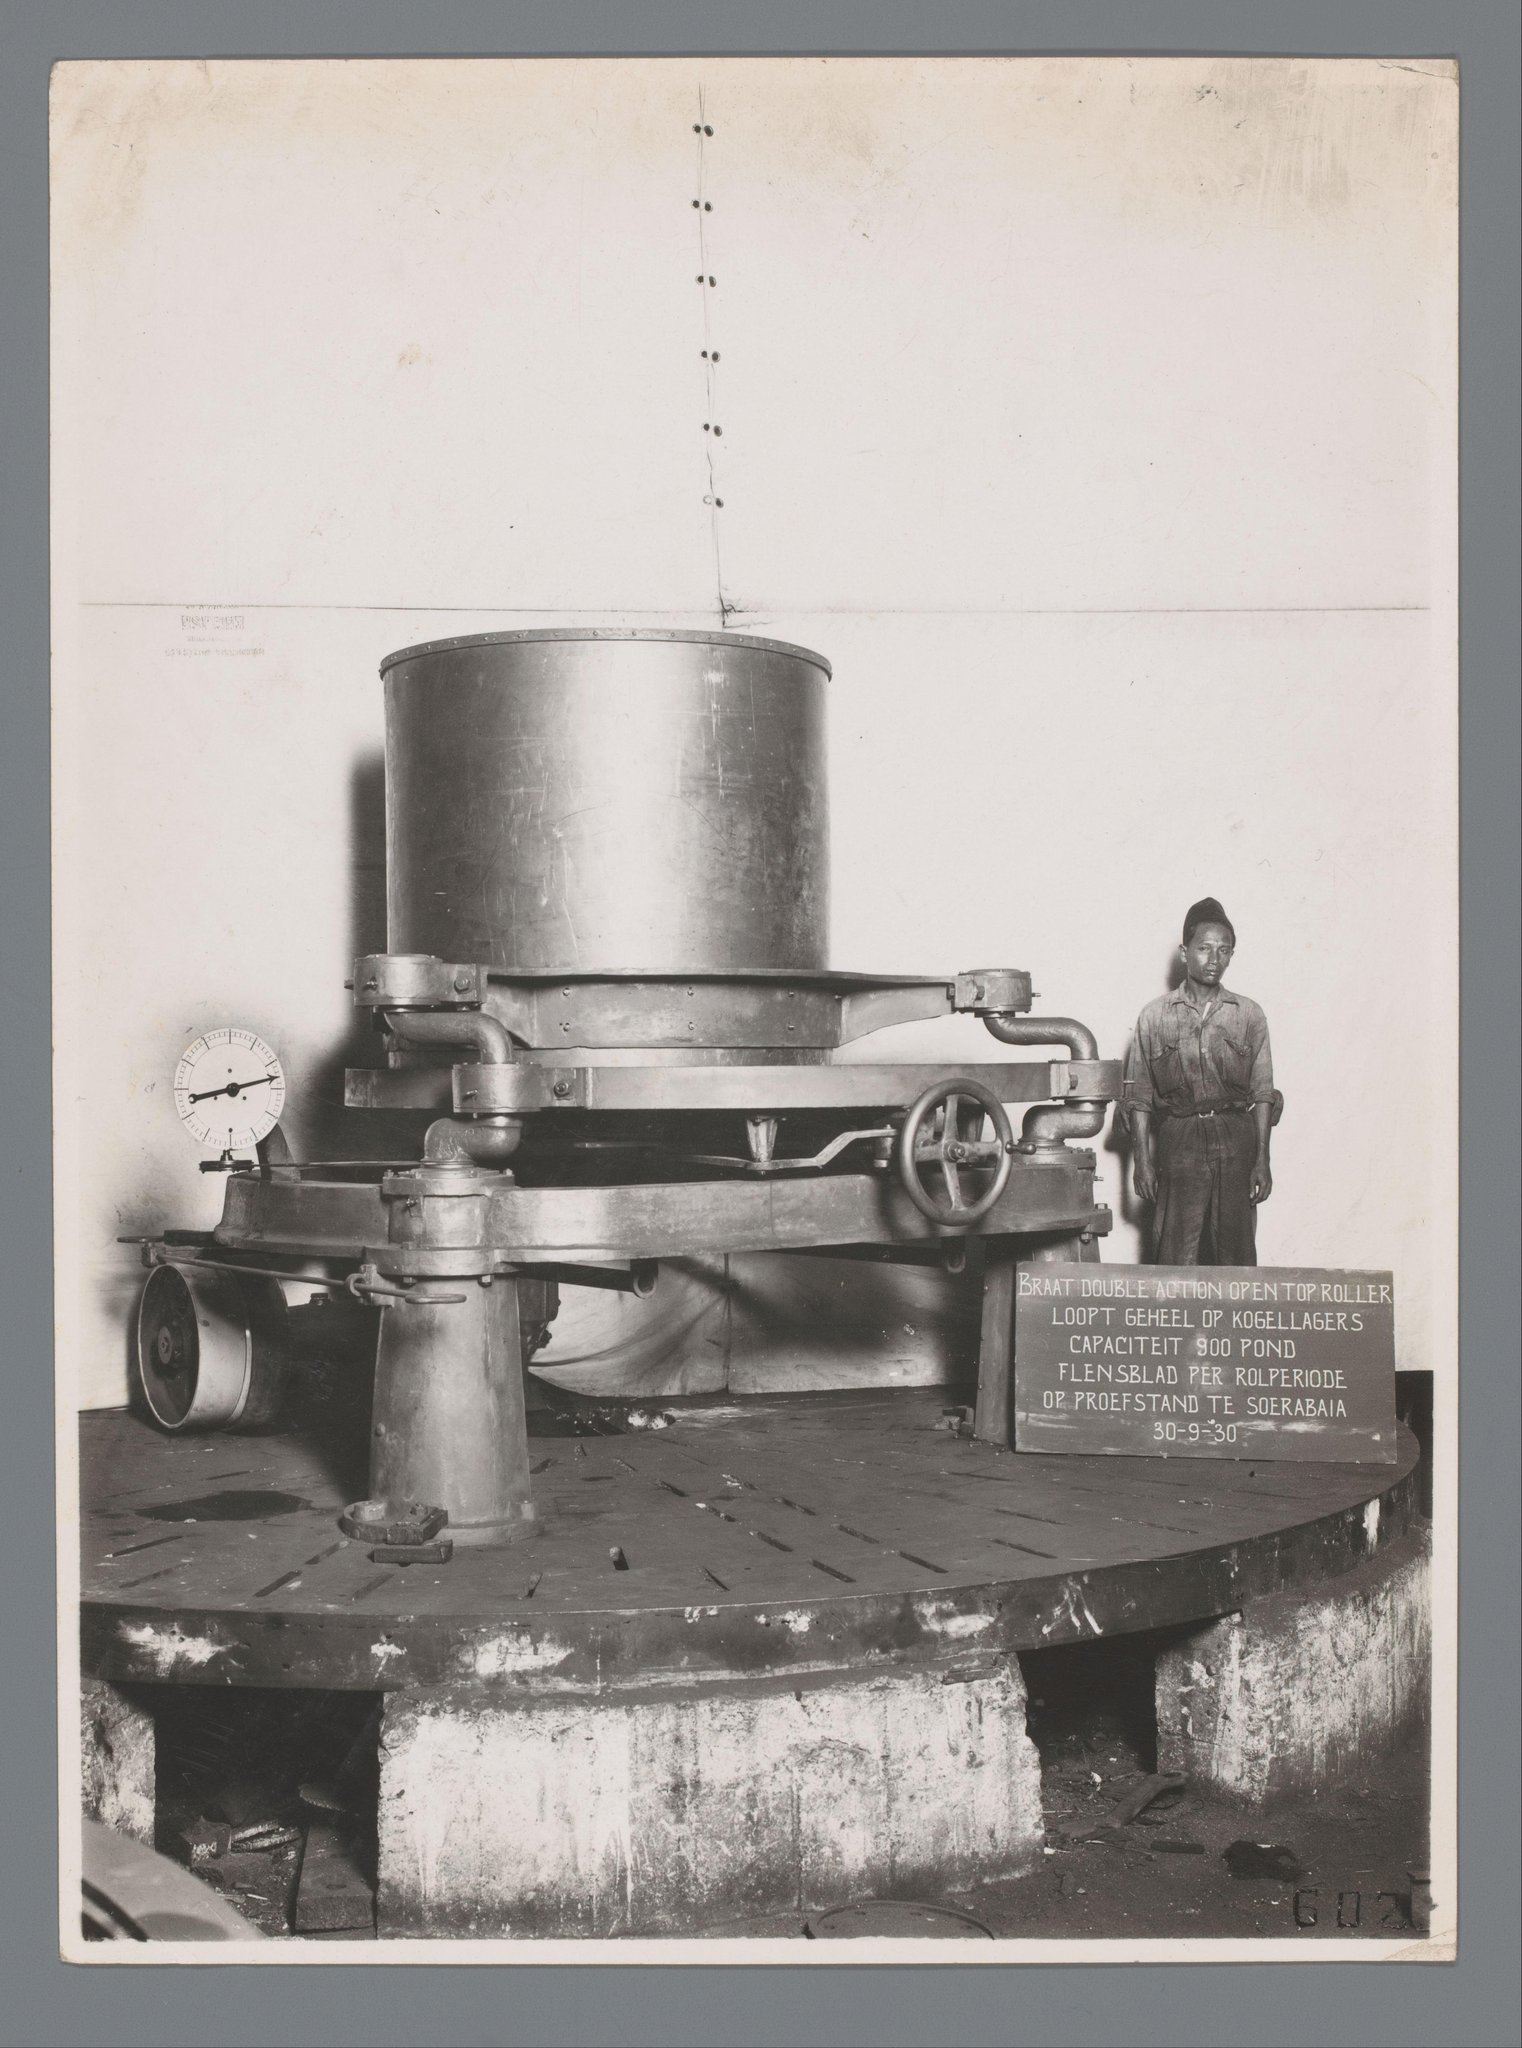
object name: photograph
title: Product Photos N.V. Machinefabriek Braat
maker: Anonymous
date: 1930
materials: photographic support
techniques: gelatin silver print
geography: surabaya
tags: colonial system, machines; parts of machines; tools and appliances, factory-interior, machine shop (+ men (labourers)), java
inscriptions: date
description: These photographs feature machines manufactured by Machinefabriek Braat in Surabaya for colonial enterprises in the Dutch East Indies (now Indonesia). These machines were primarily intended for large sugar mills. A clearly displayed text board provides an explanation of the machines and Indonesian factory workers are included to give a sense of scale for their size.